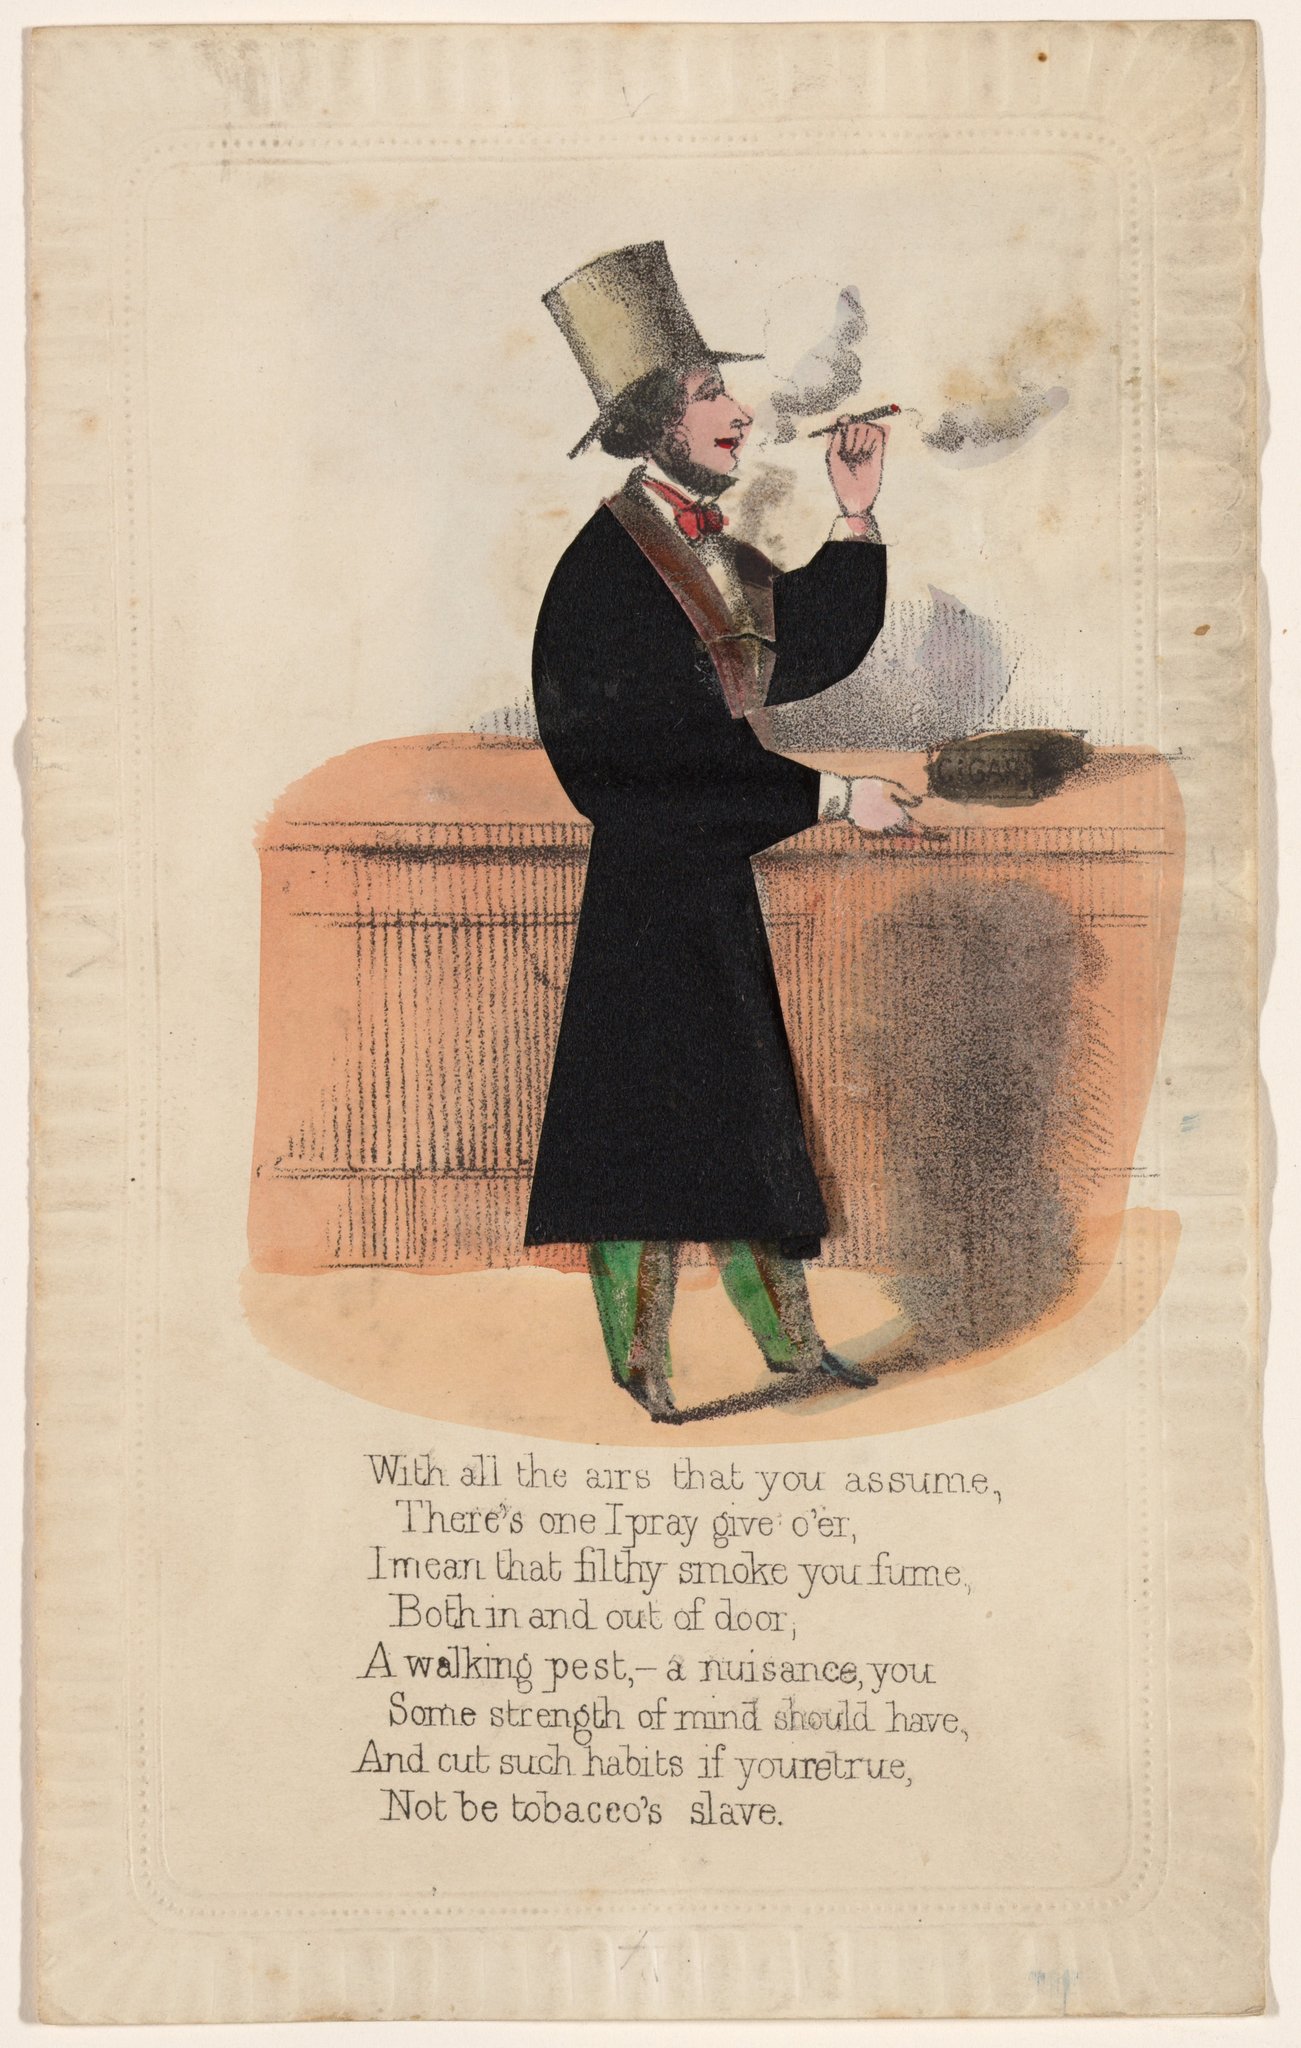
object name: valentine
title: Comic Valentine (anti-smoking)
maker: Anonymous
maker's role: artist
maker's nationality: british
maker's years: 1800-1899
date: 1850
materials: felt, paper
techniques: embossing, hand coloring, lithograph